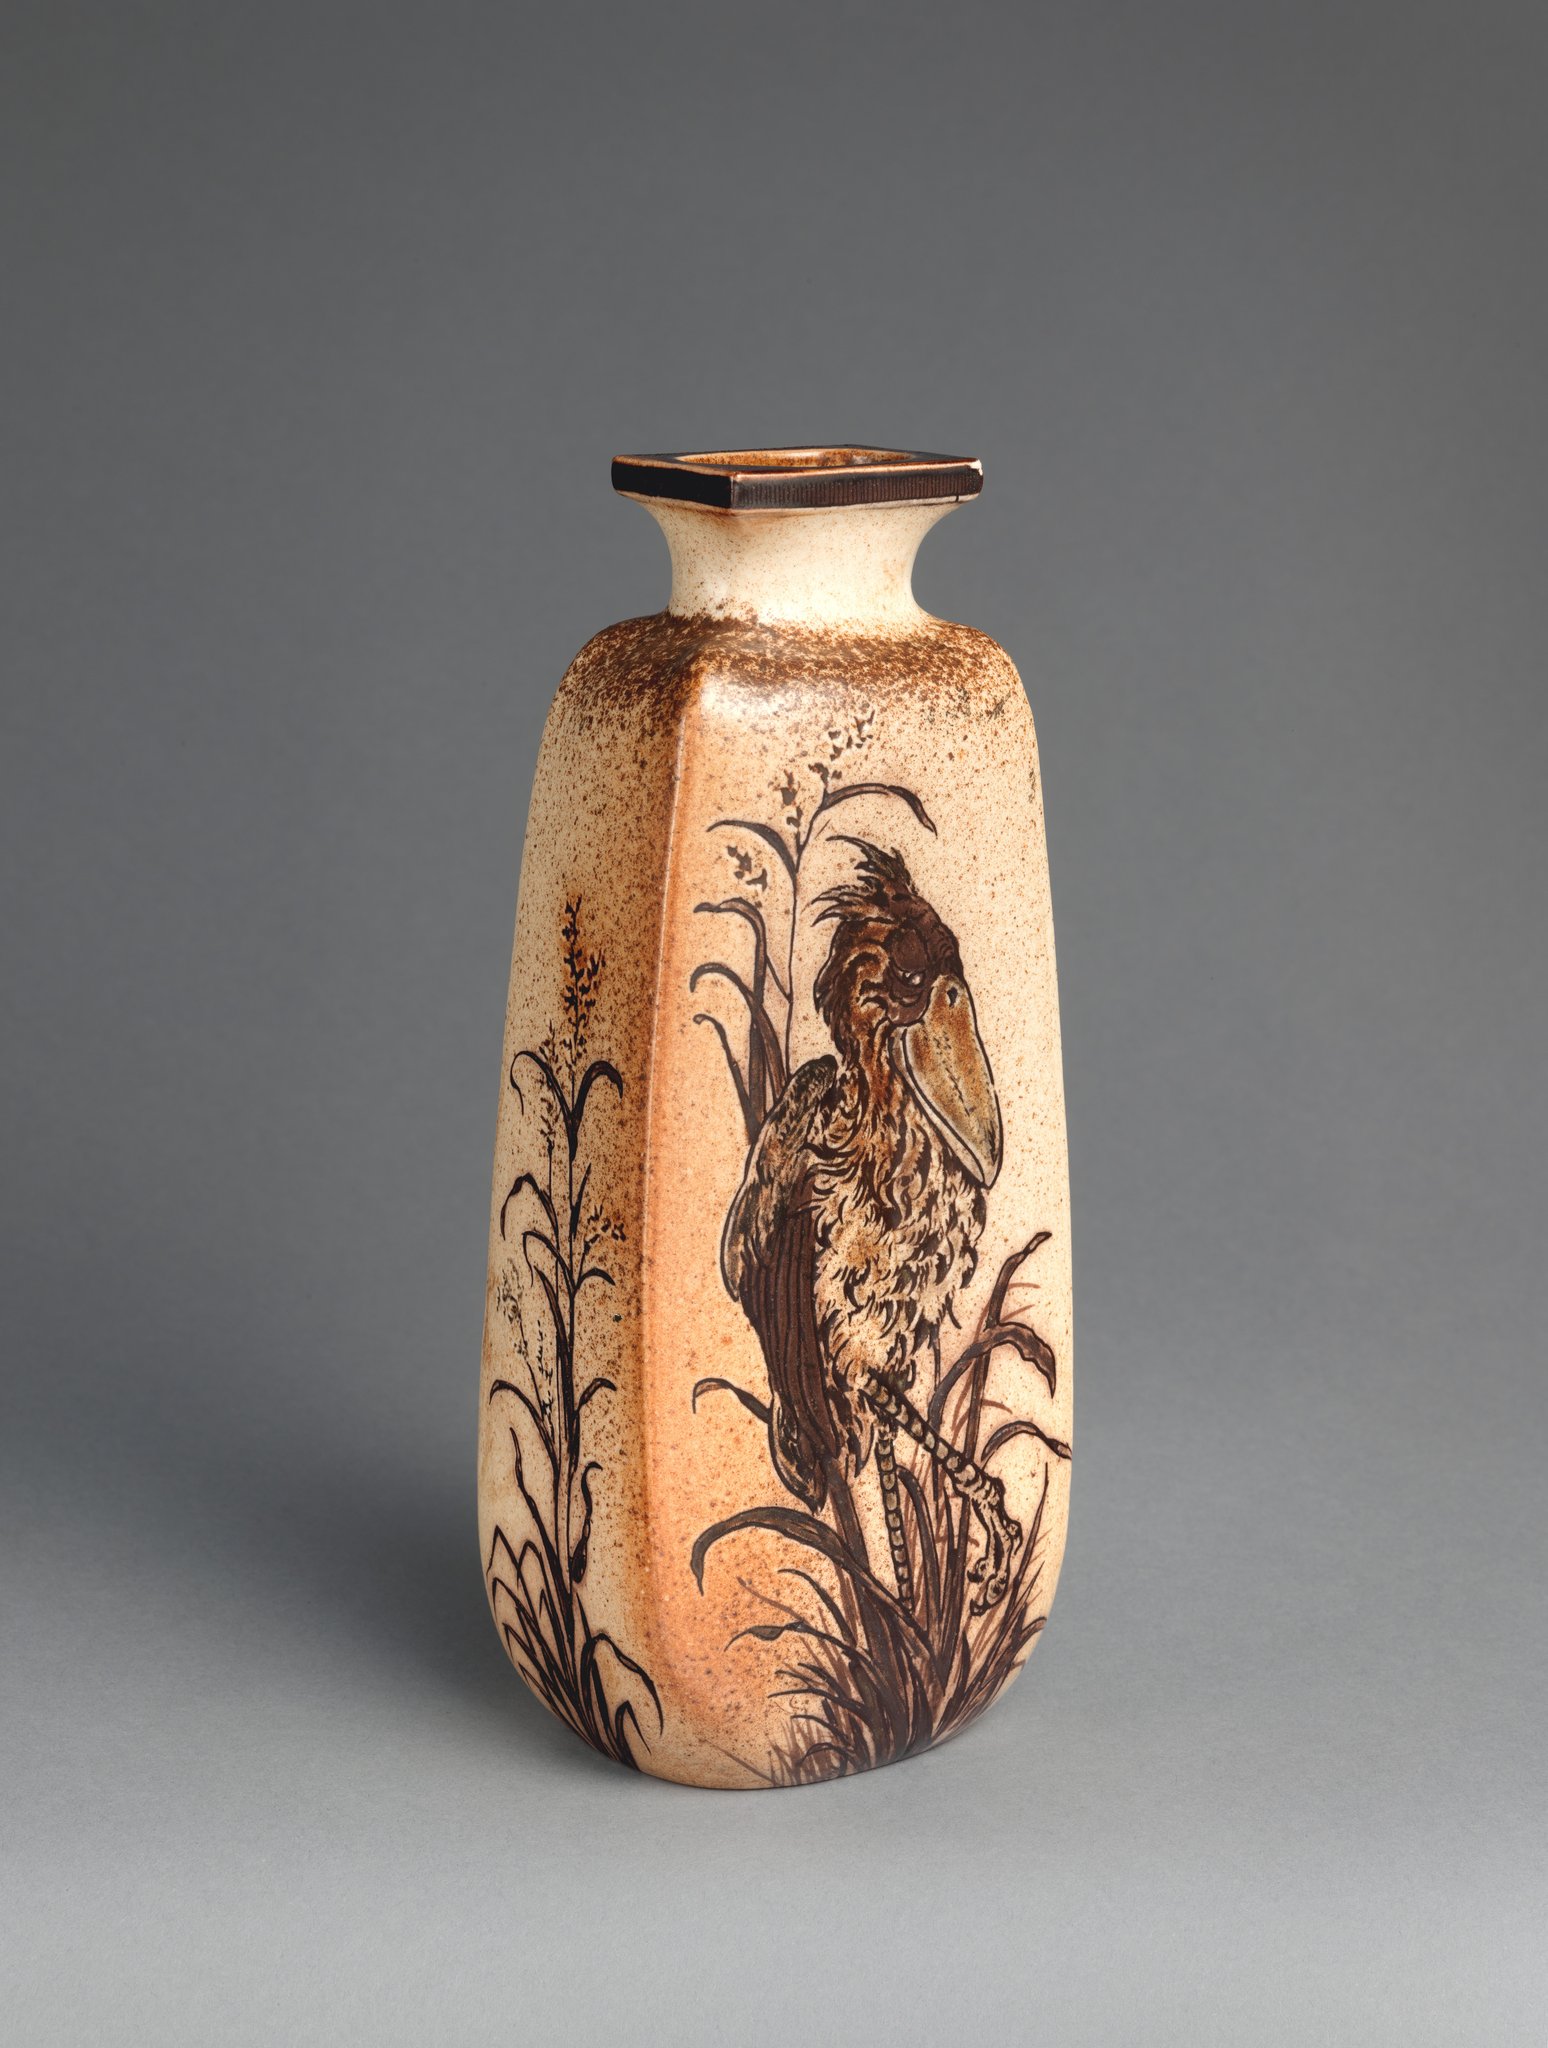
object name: vase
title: Bottle vase with birds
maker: r. w. martin and brothers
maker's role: maker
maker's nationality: british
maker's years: 1873-1915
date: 1899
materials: stoneware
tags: birds,plants